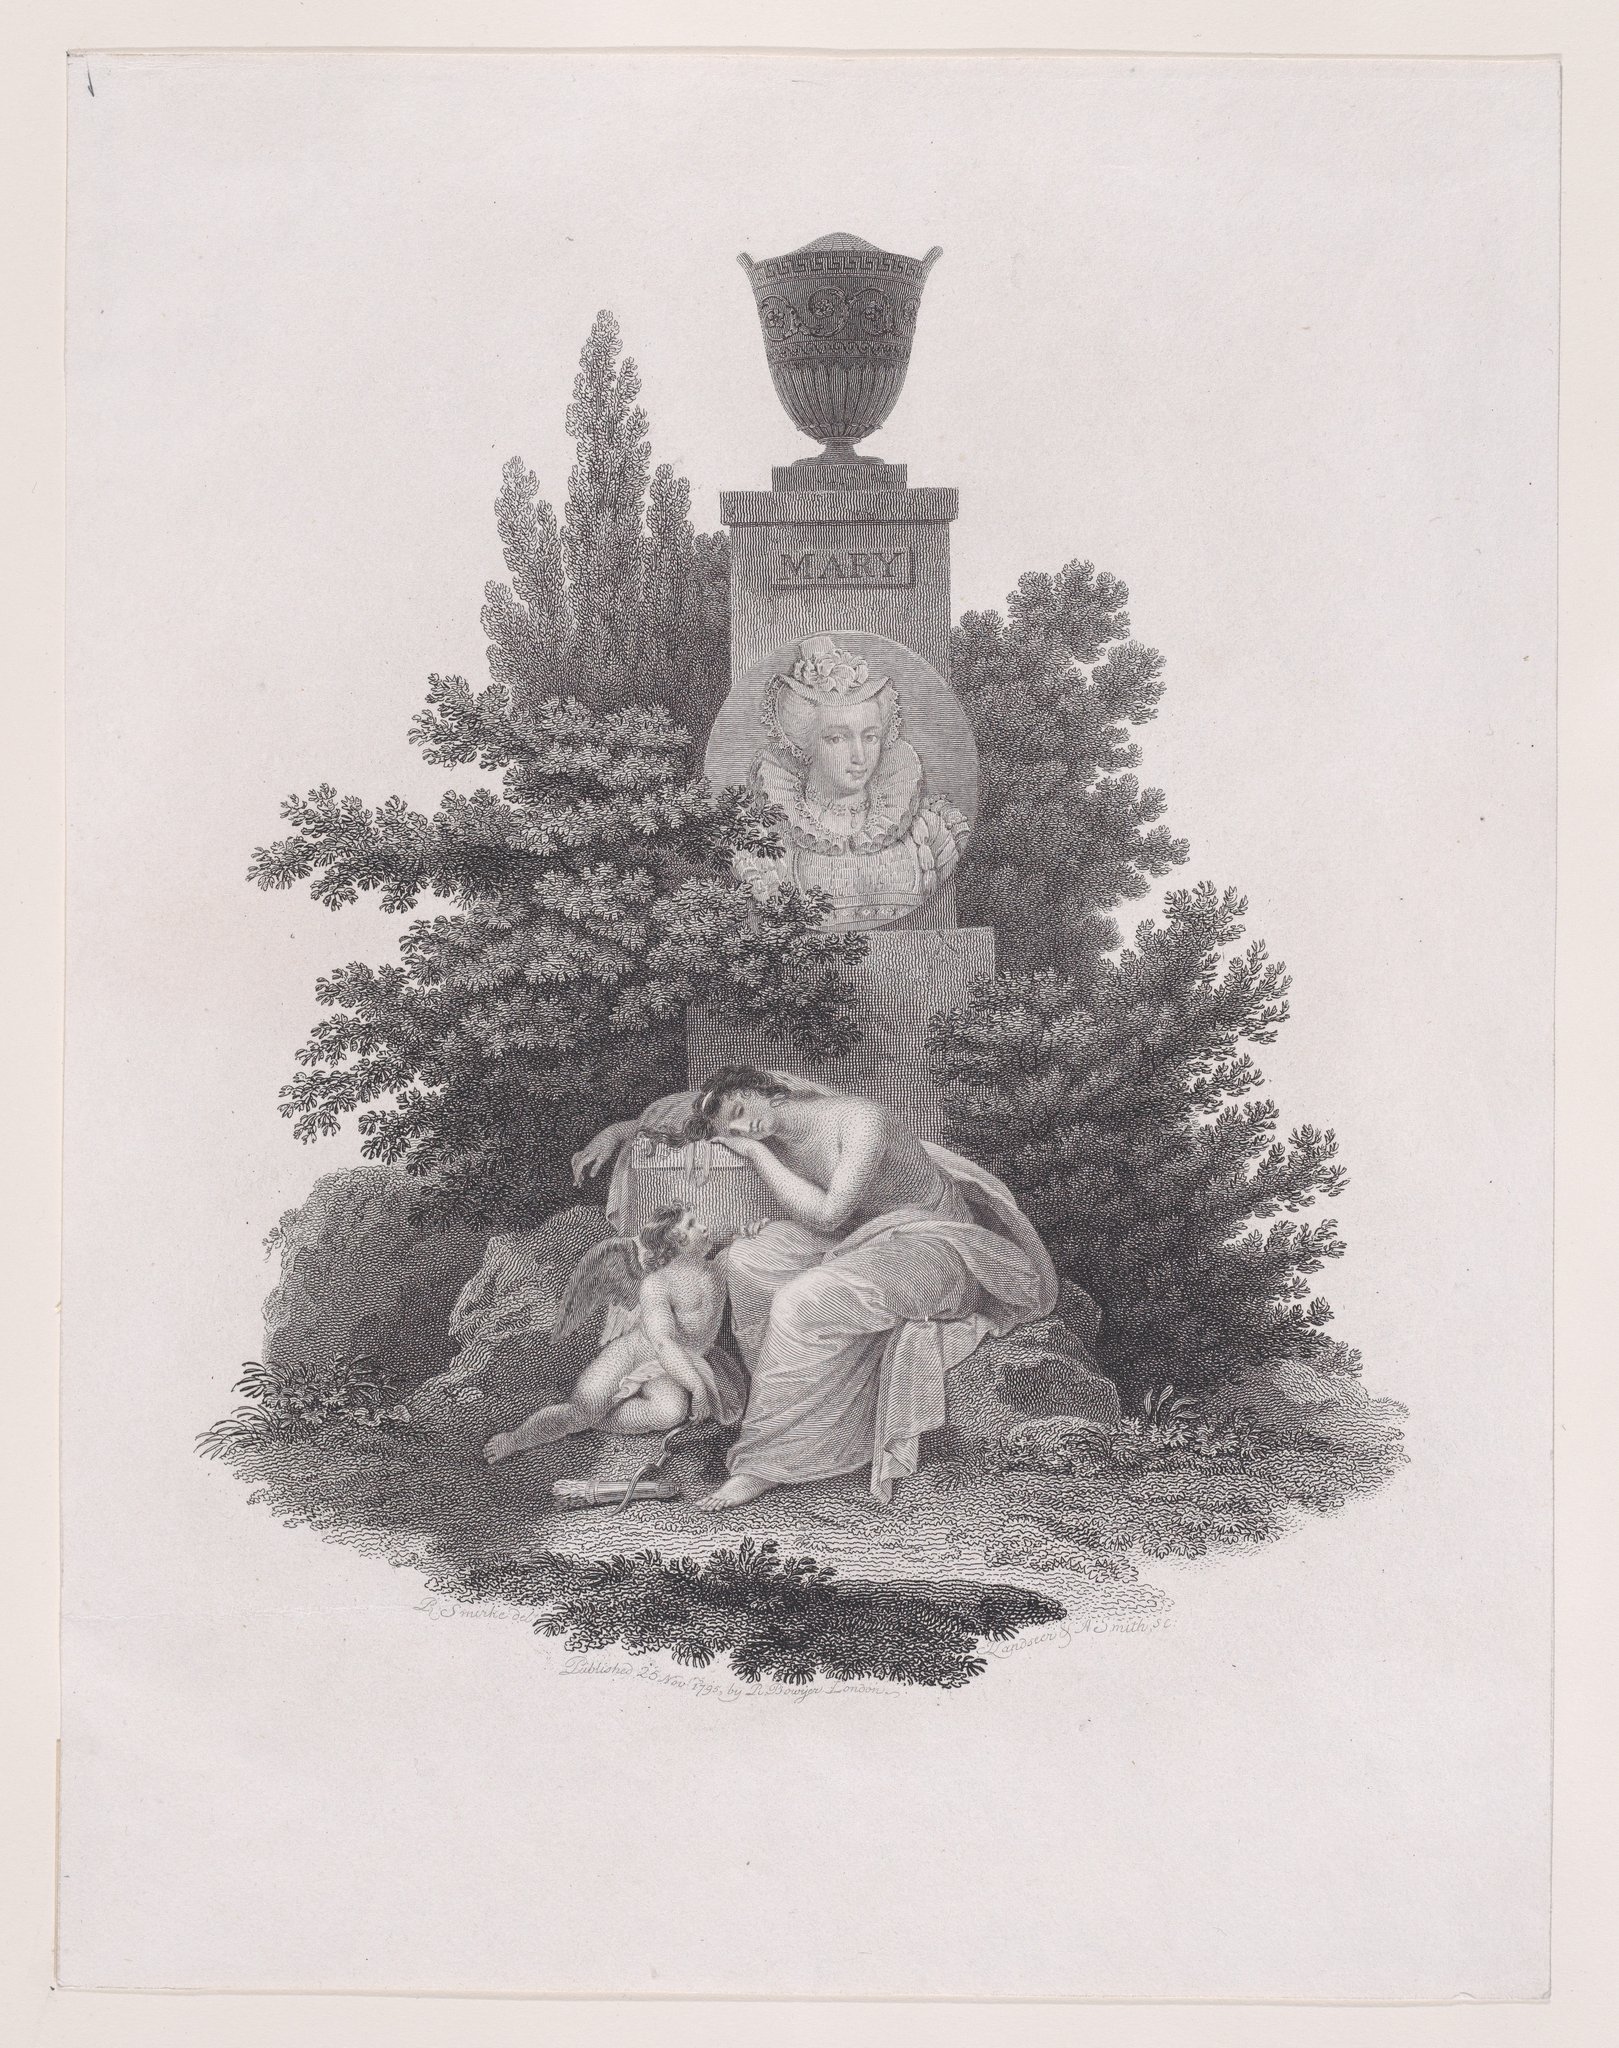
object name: print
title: Monument of Mary, Queen of Scots (from "The History of England")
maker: john george landseer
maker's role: artist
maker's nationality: british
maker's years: 1763-1852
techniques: engraving, etching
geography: england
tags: monuments,cupid,mary queen of scots